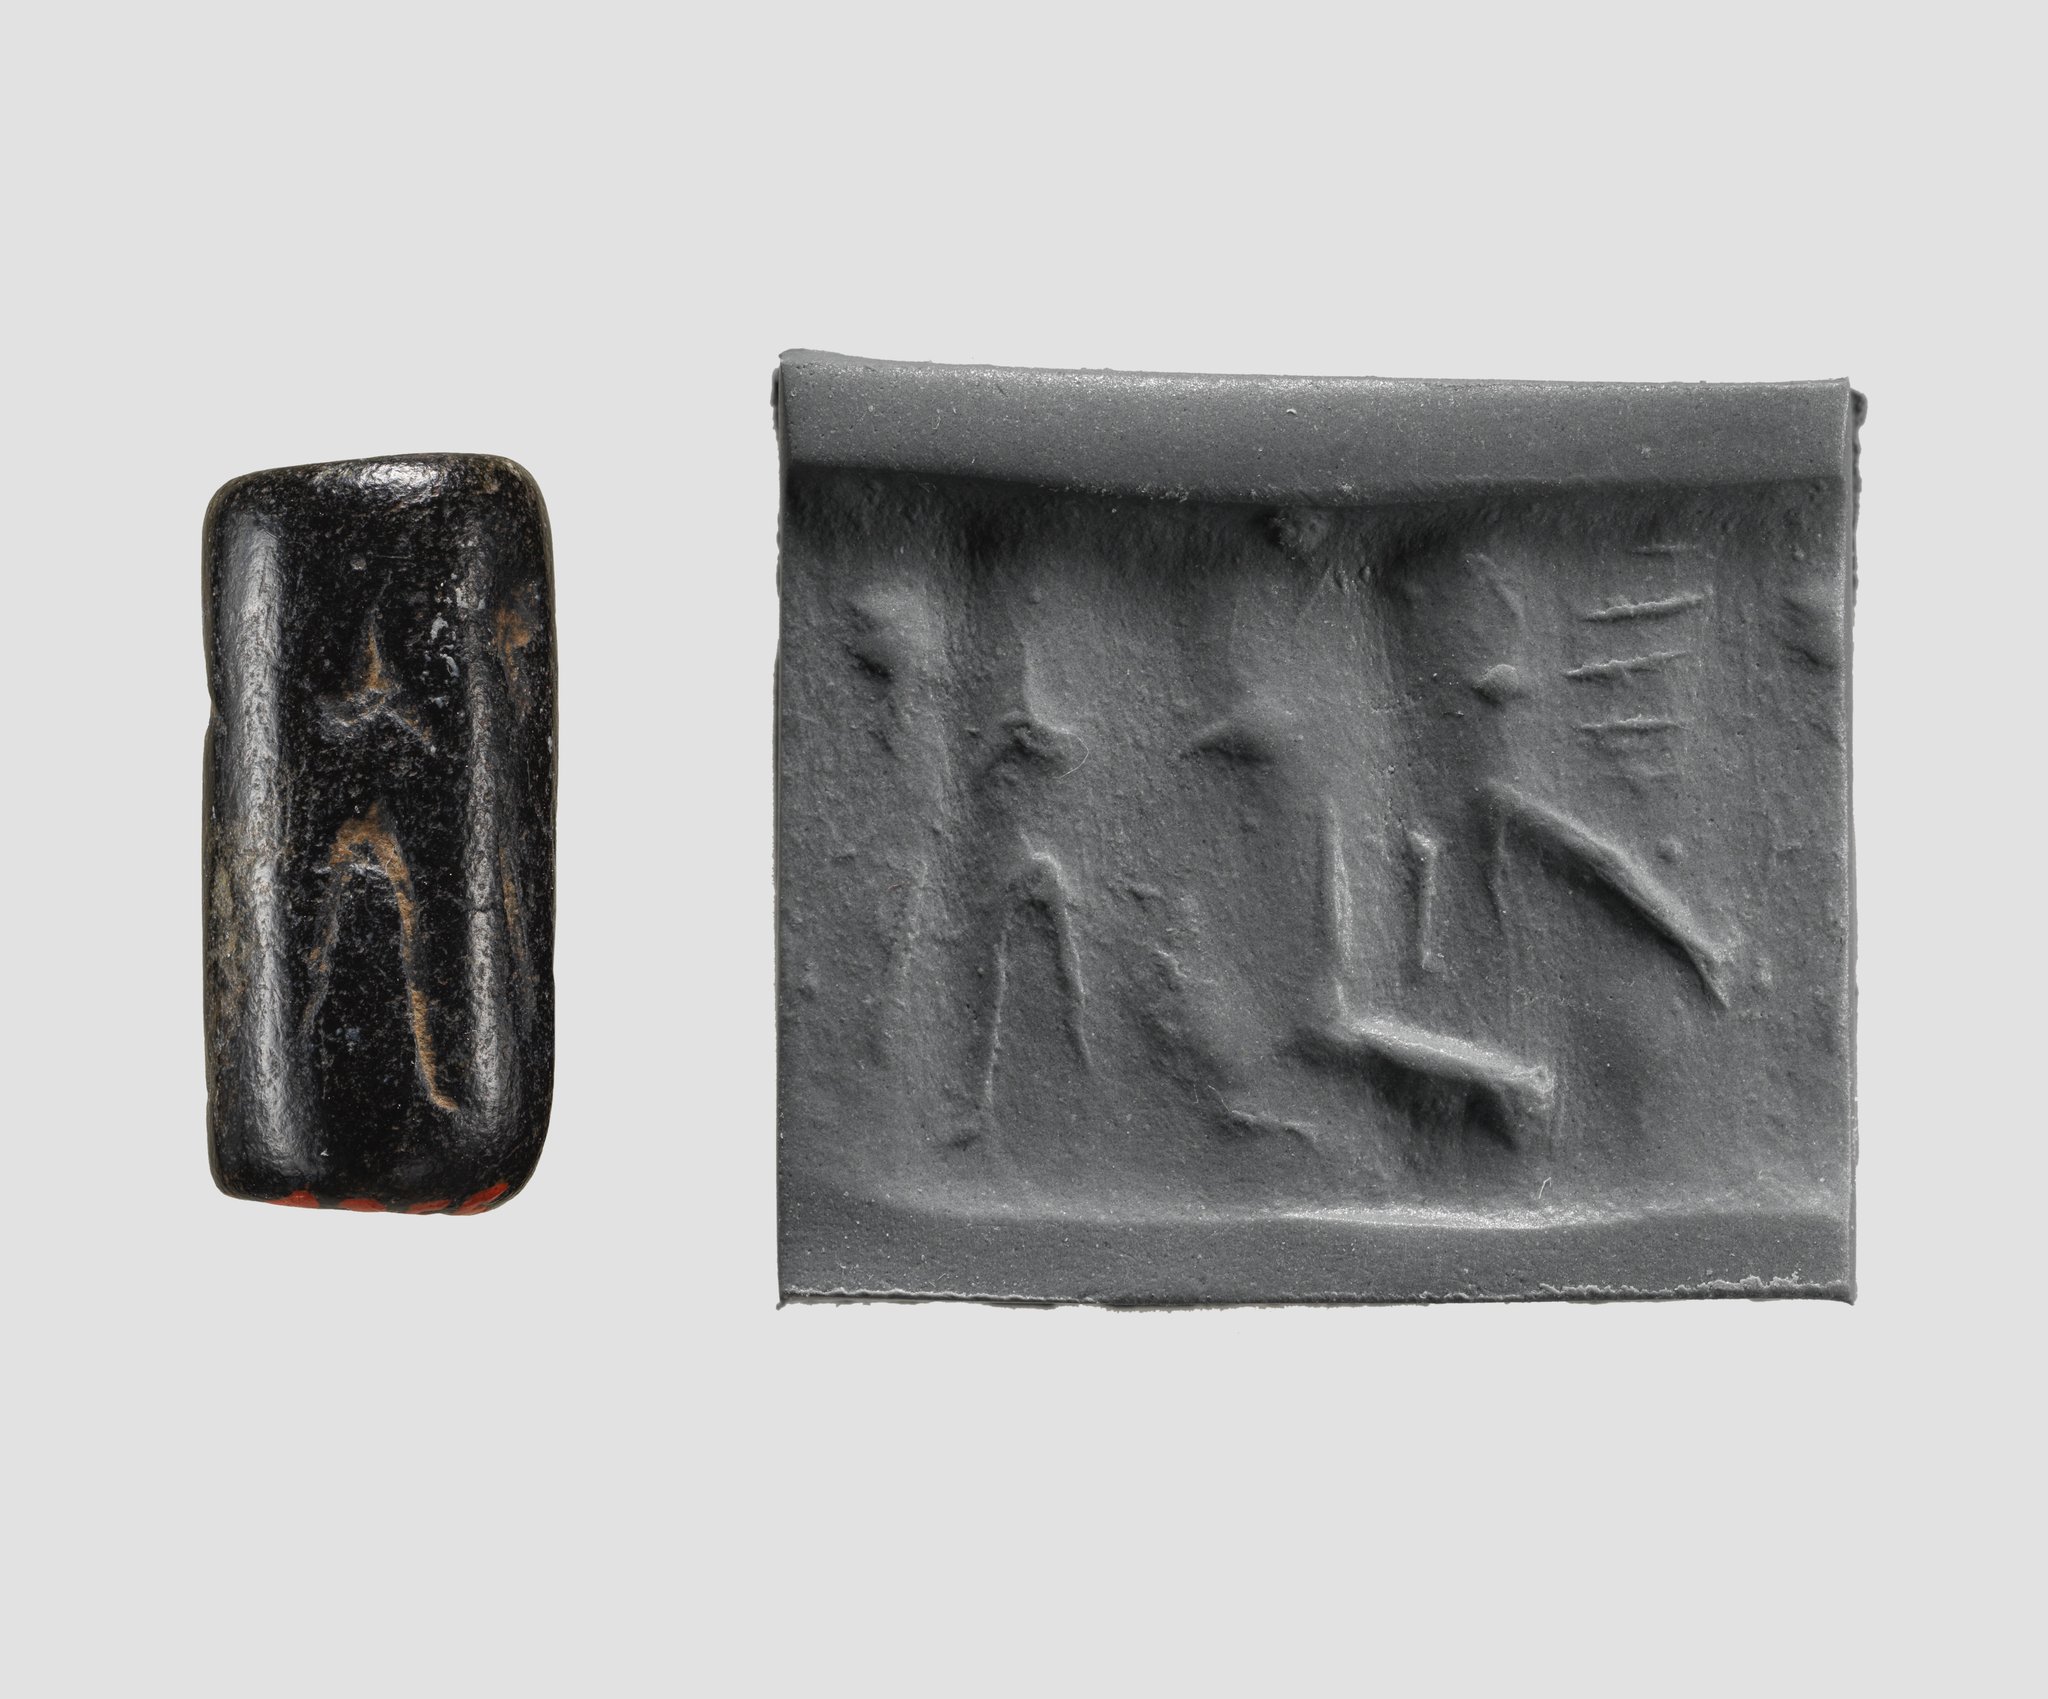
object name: cylinder seal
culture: cypriot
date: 1200-1001 BCE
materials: stone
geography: cyprus